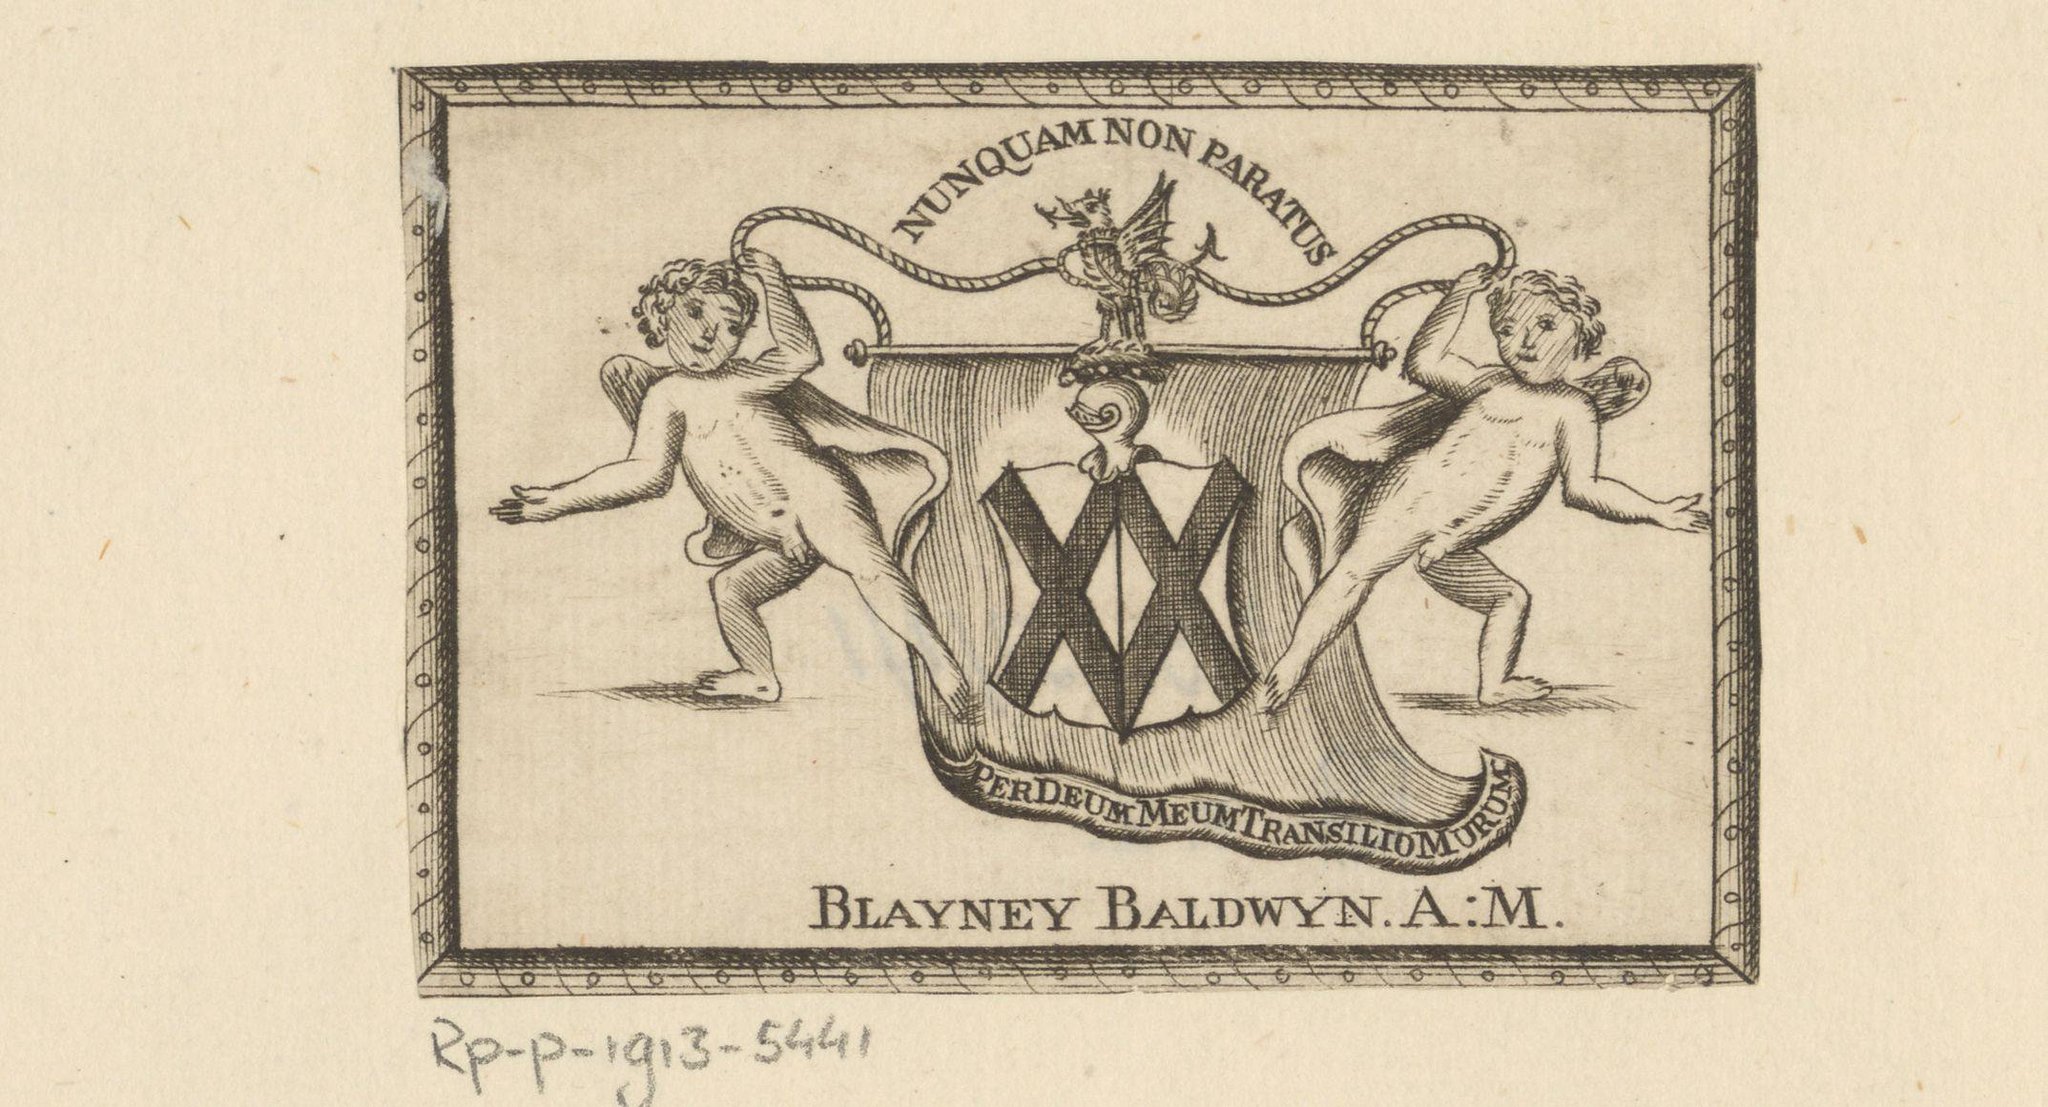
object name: bookplate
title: Nunquam non paratus per deum meum transilio murum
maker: Anonymous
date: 1700-1799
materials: paper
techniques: engraving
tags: armorial bearing, heraldry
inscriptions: collector's mark: Lugt 2760, collector's mark: Lugt 2233